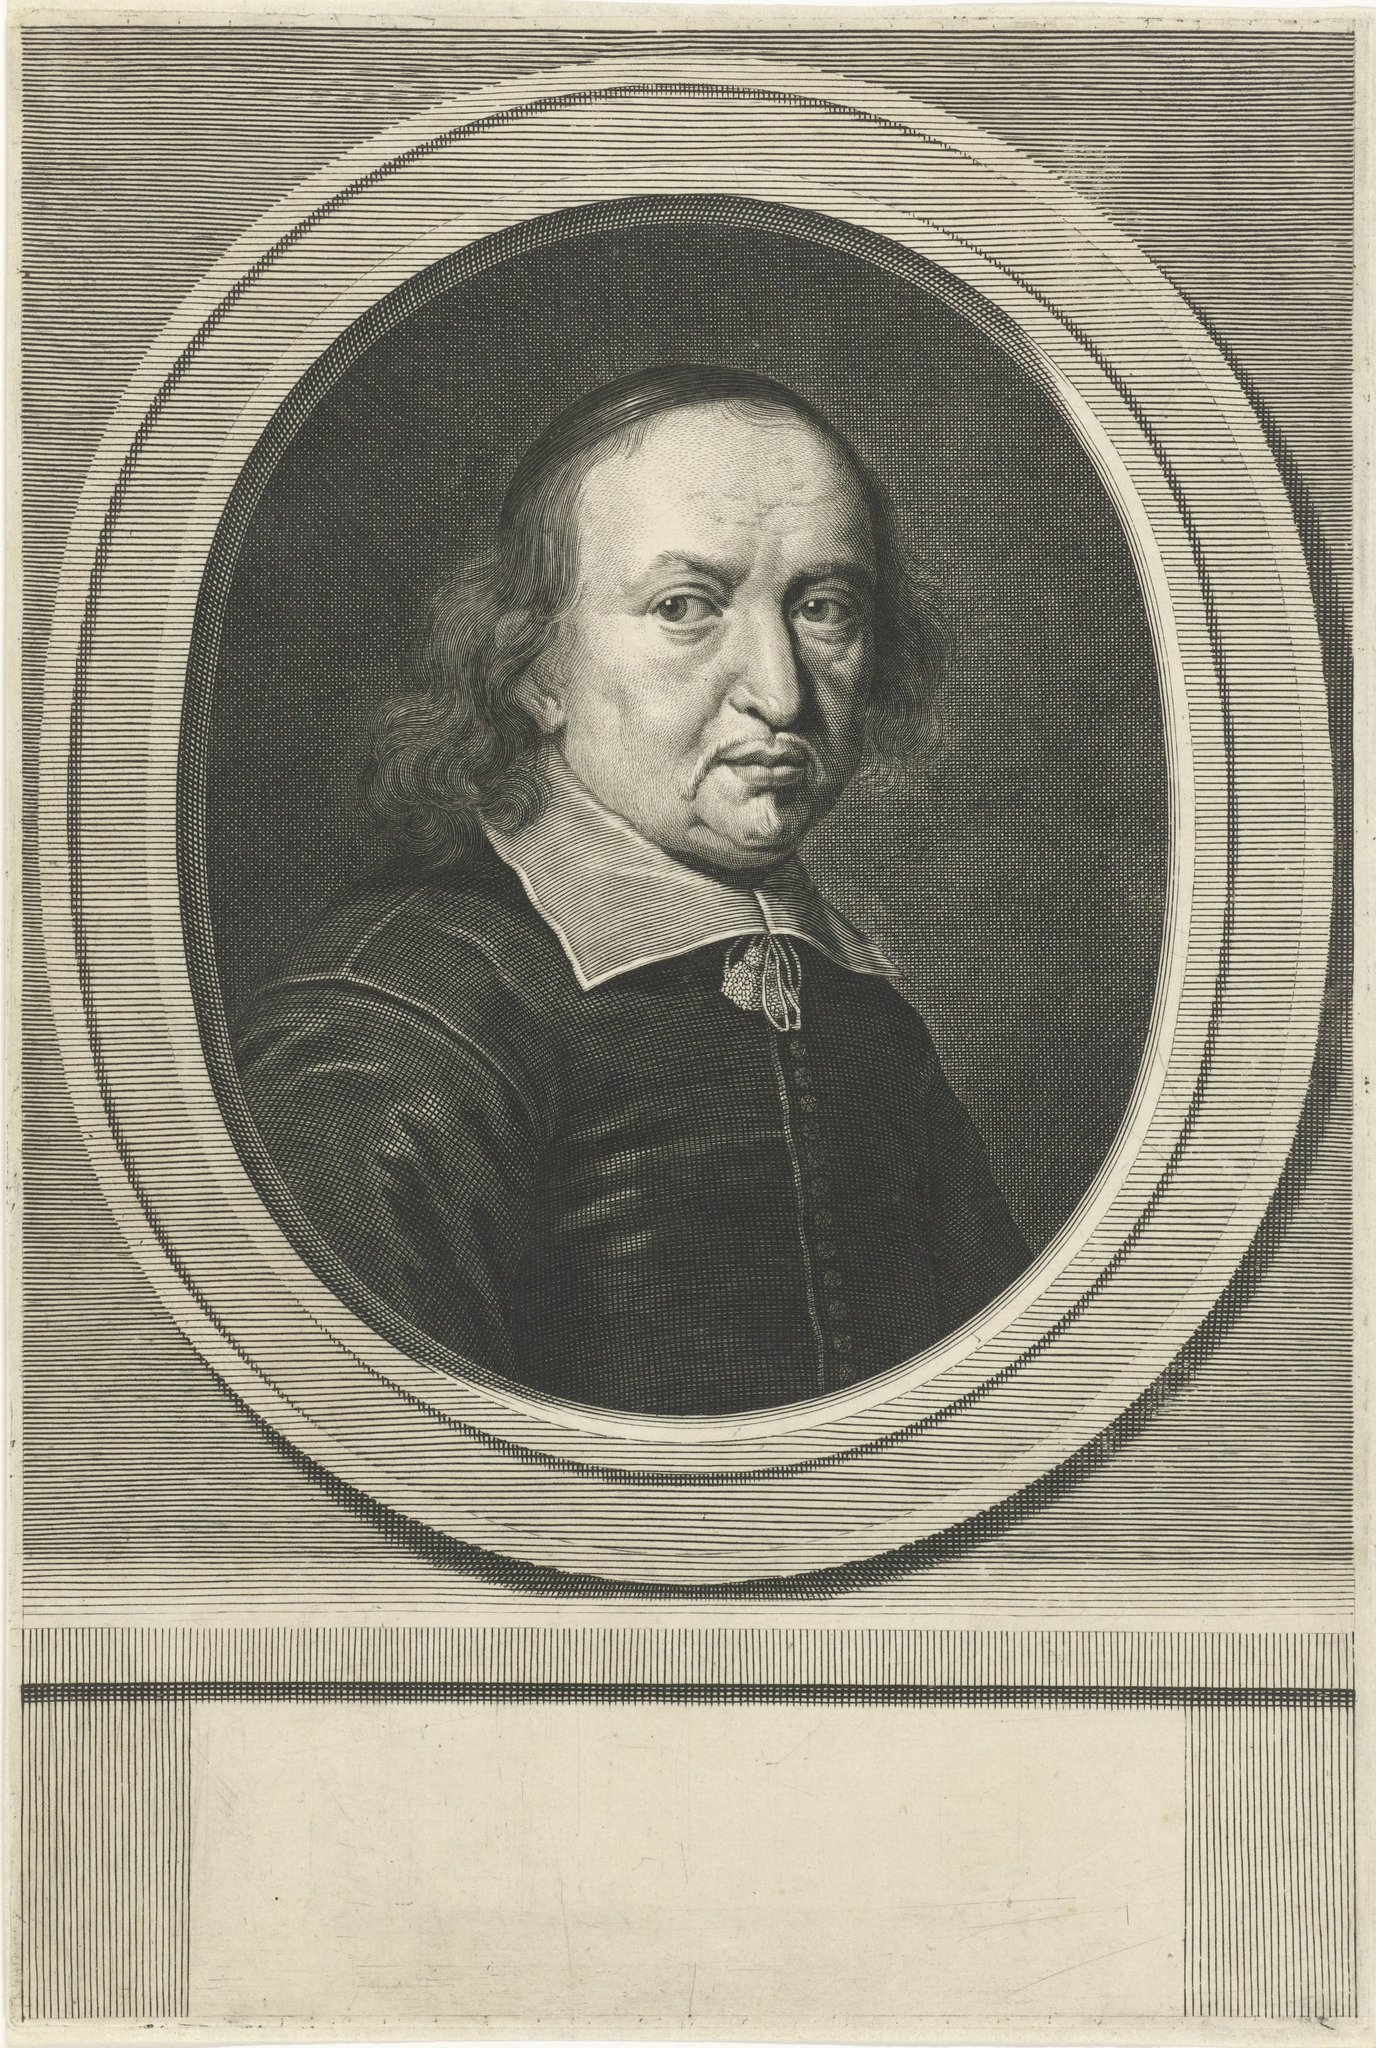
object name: print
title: Portret van Reinhold Curike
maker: jan van munnickhuysen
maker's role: draughtsman, print maker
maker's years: 1655-1701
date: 1685-1721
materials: paper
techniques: engraving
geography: netherlands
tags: reinhold curike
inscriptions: collector's mark: Lugt 2228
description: Portret van Reinhold Curike, secretaris te Danzig.